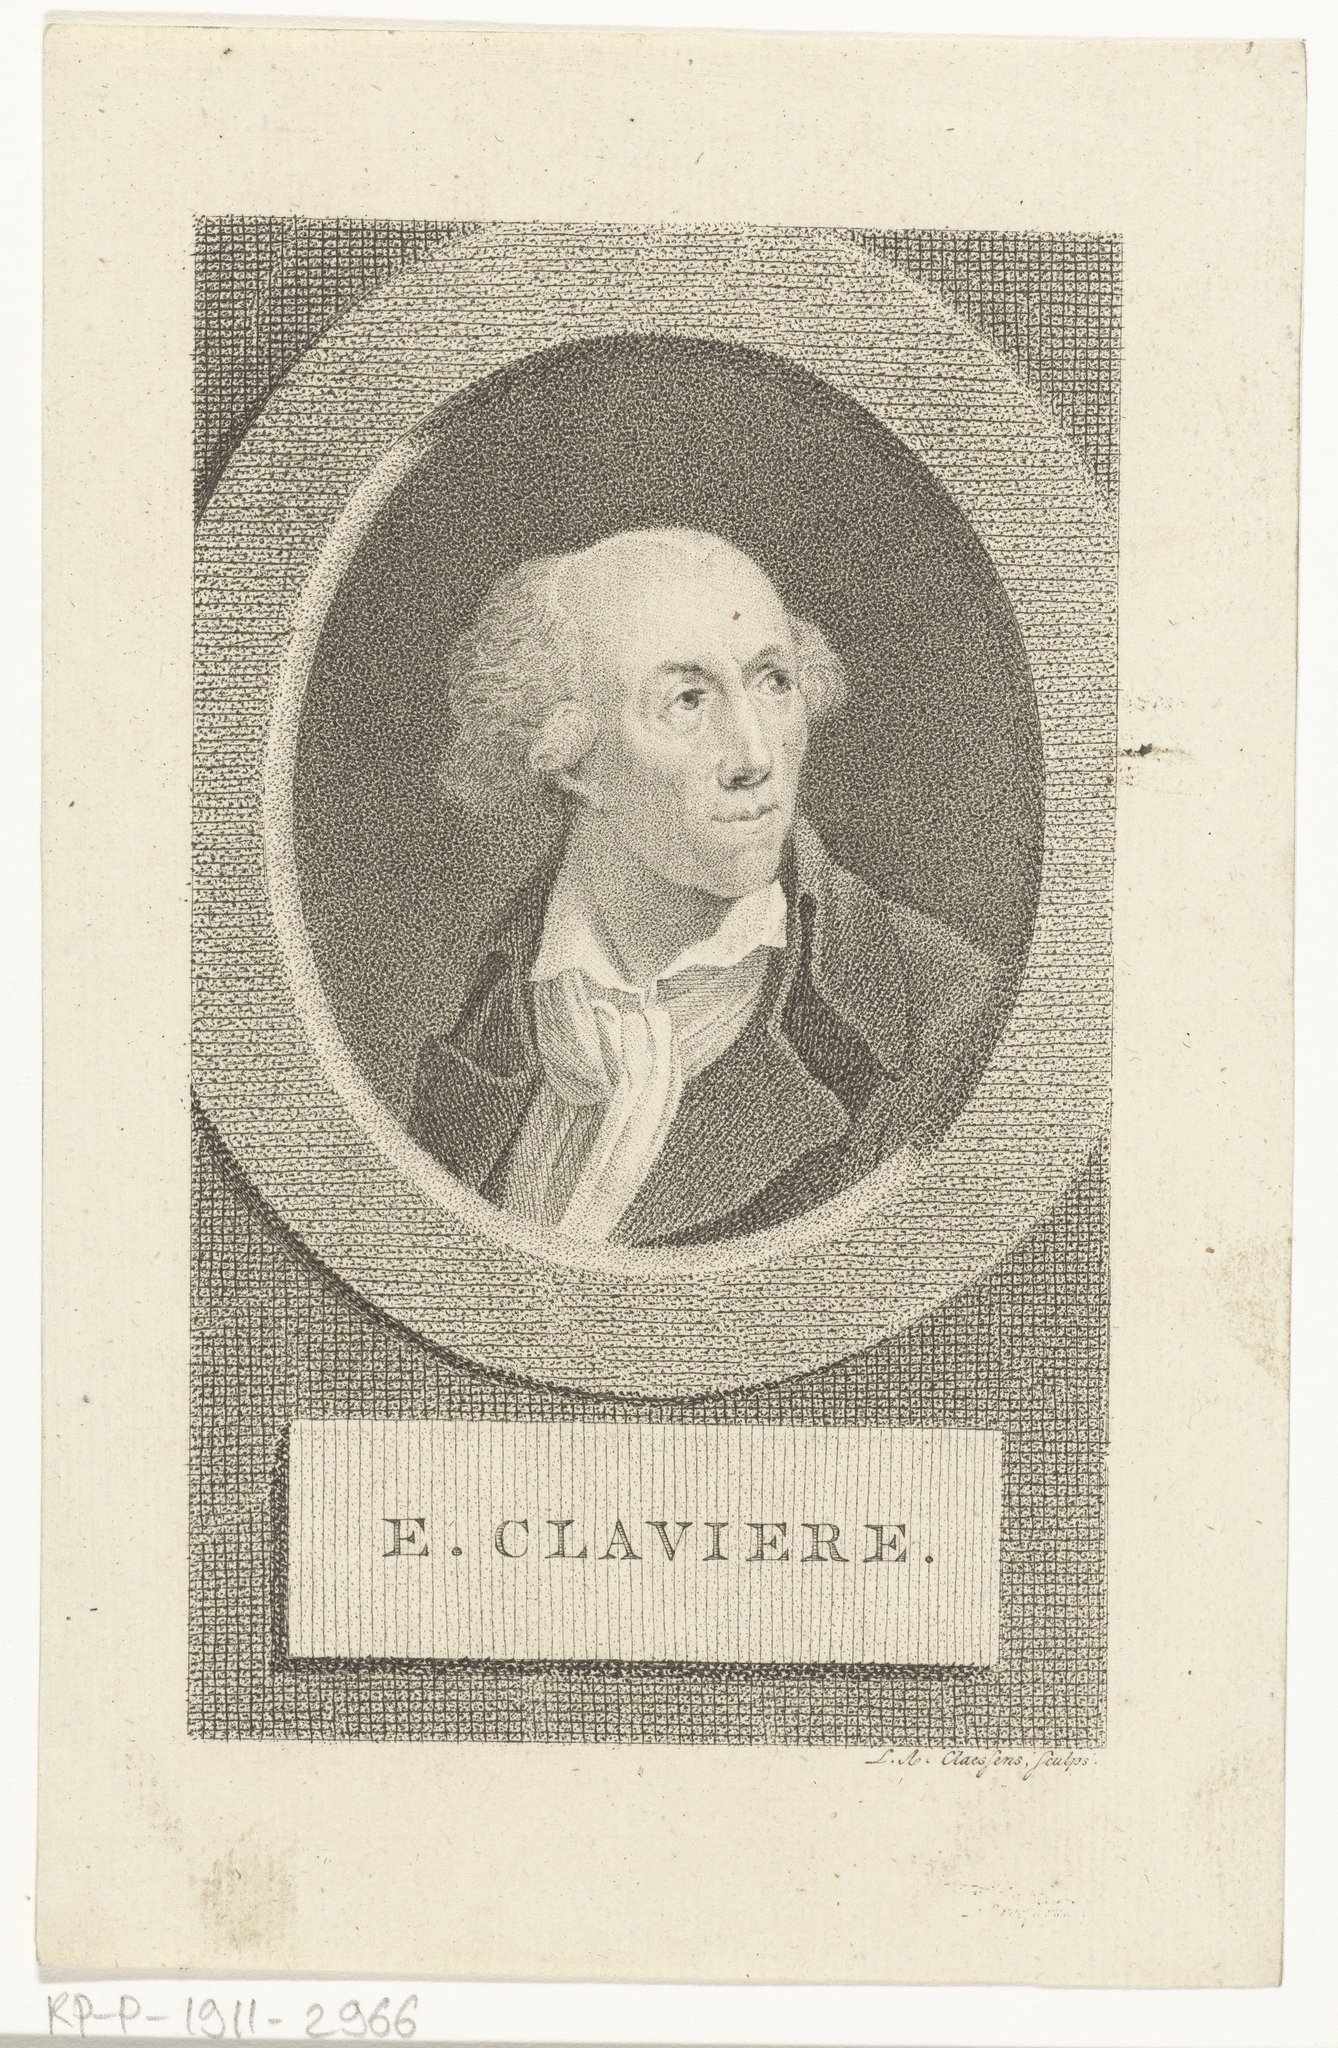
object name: print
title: Portret van Étienne Clavière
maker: lambertus antonius claessens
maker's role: draughtsman, print maker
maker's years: 1763-1834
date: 1792-1808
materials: paper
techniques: engraving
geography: amsterdam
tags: politician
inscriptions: collector's mark: Lugt 2228